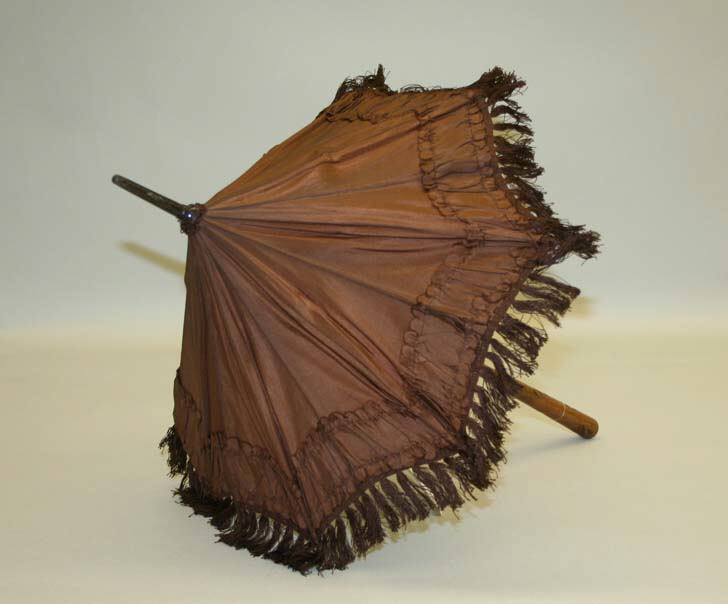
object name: parasol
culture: american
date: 1835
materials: silk